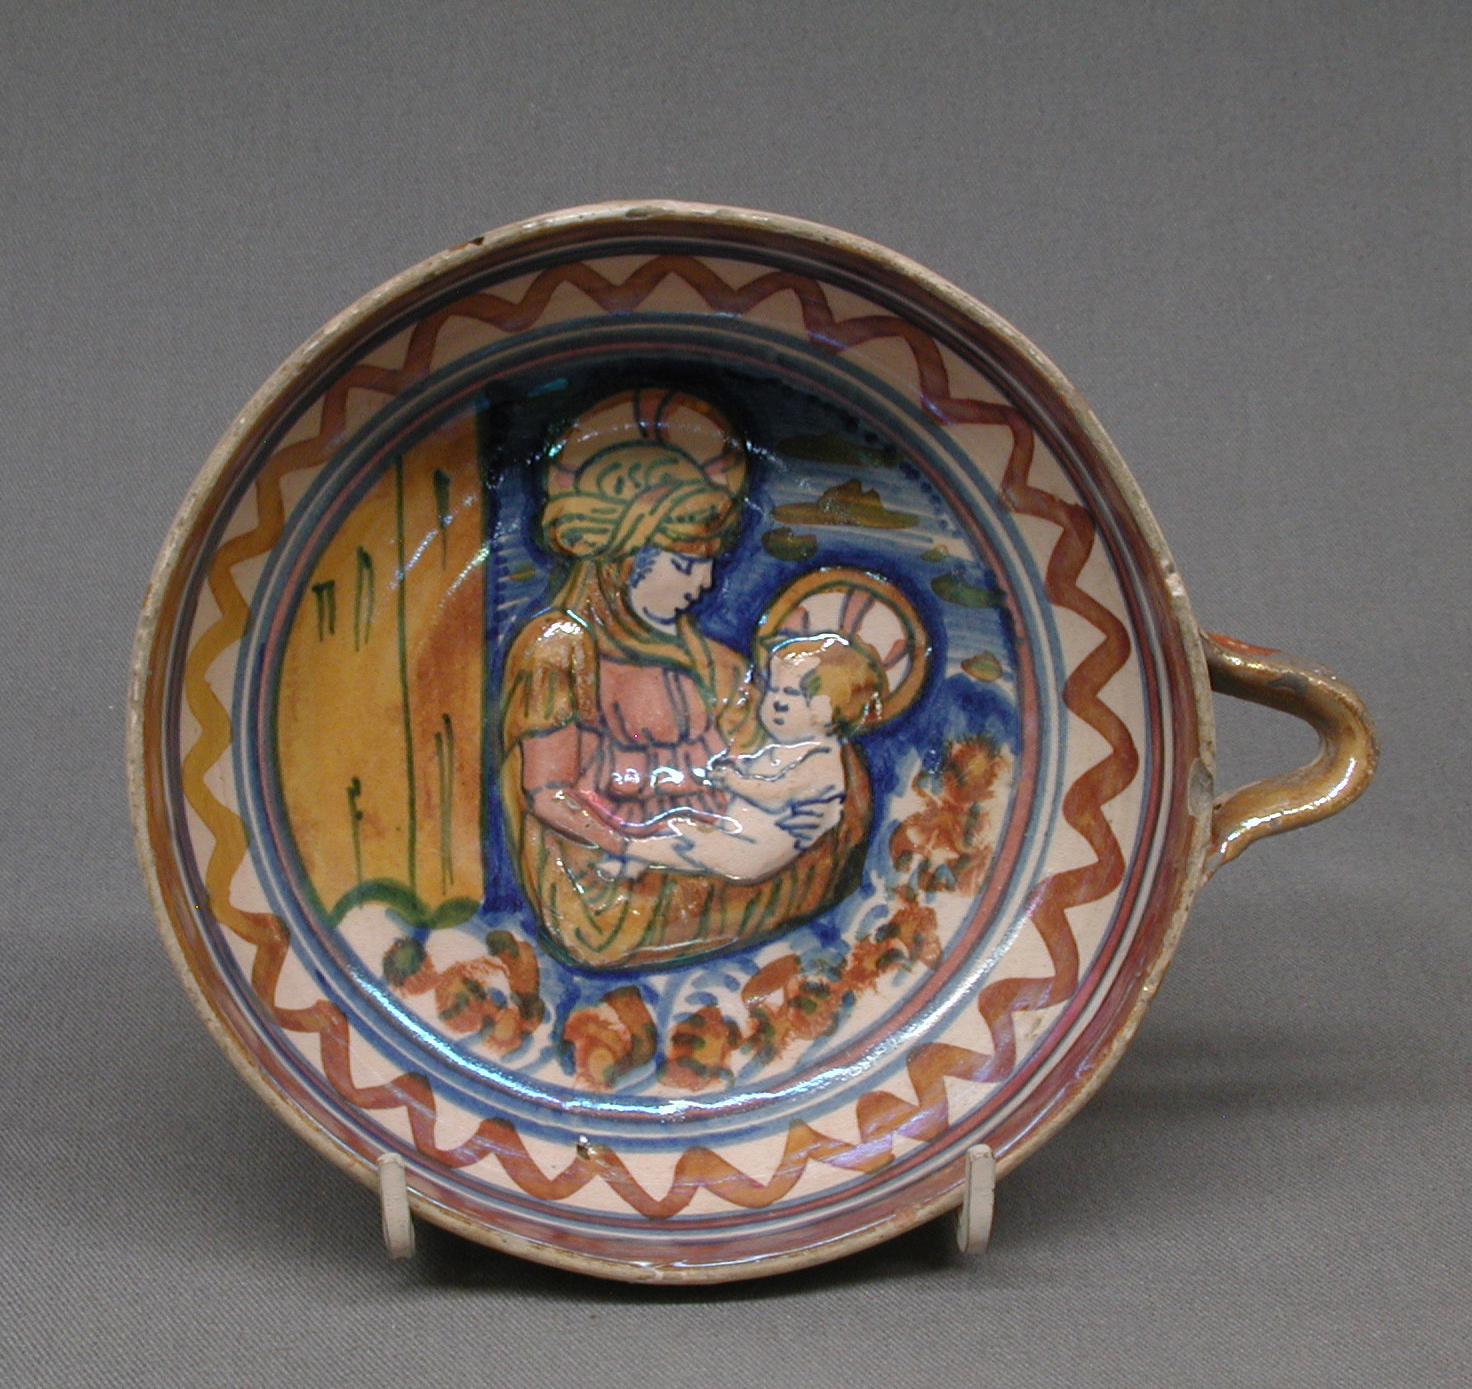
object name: bowl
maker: maestro prestino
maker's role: maker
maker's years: 1500-1600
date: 1535-1550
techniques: maiolica, glazing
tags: infants,women